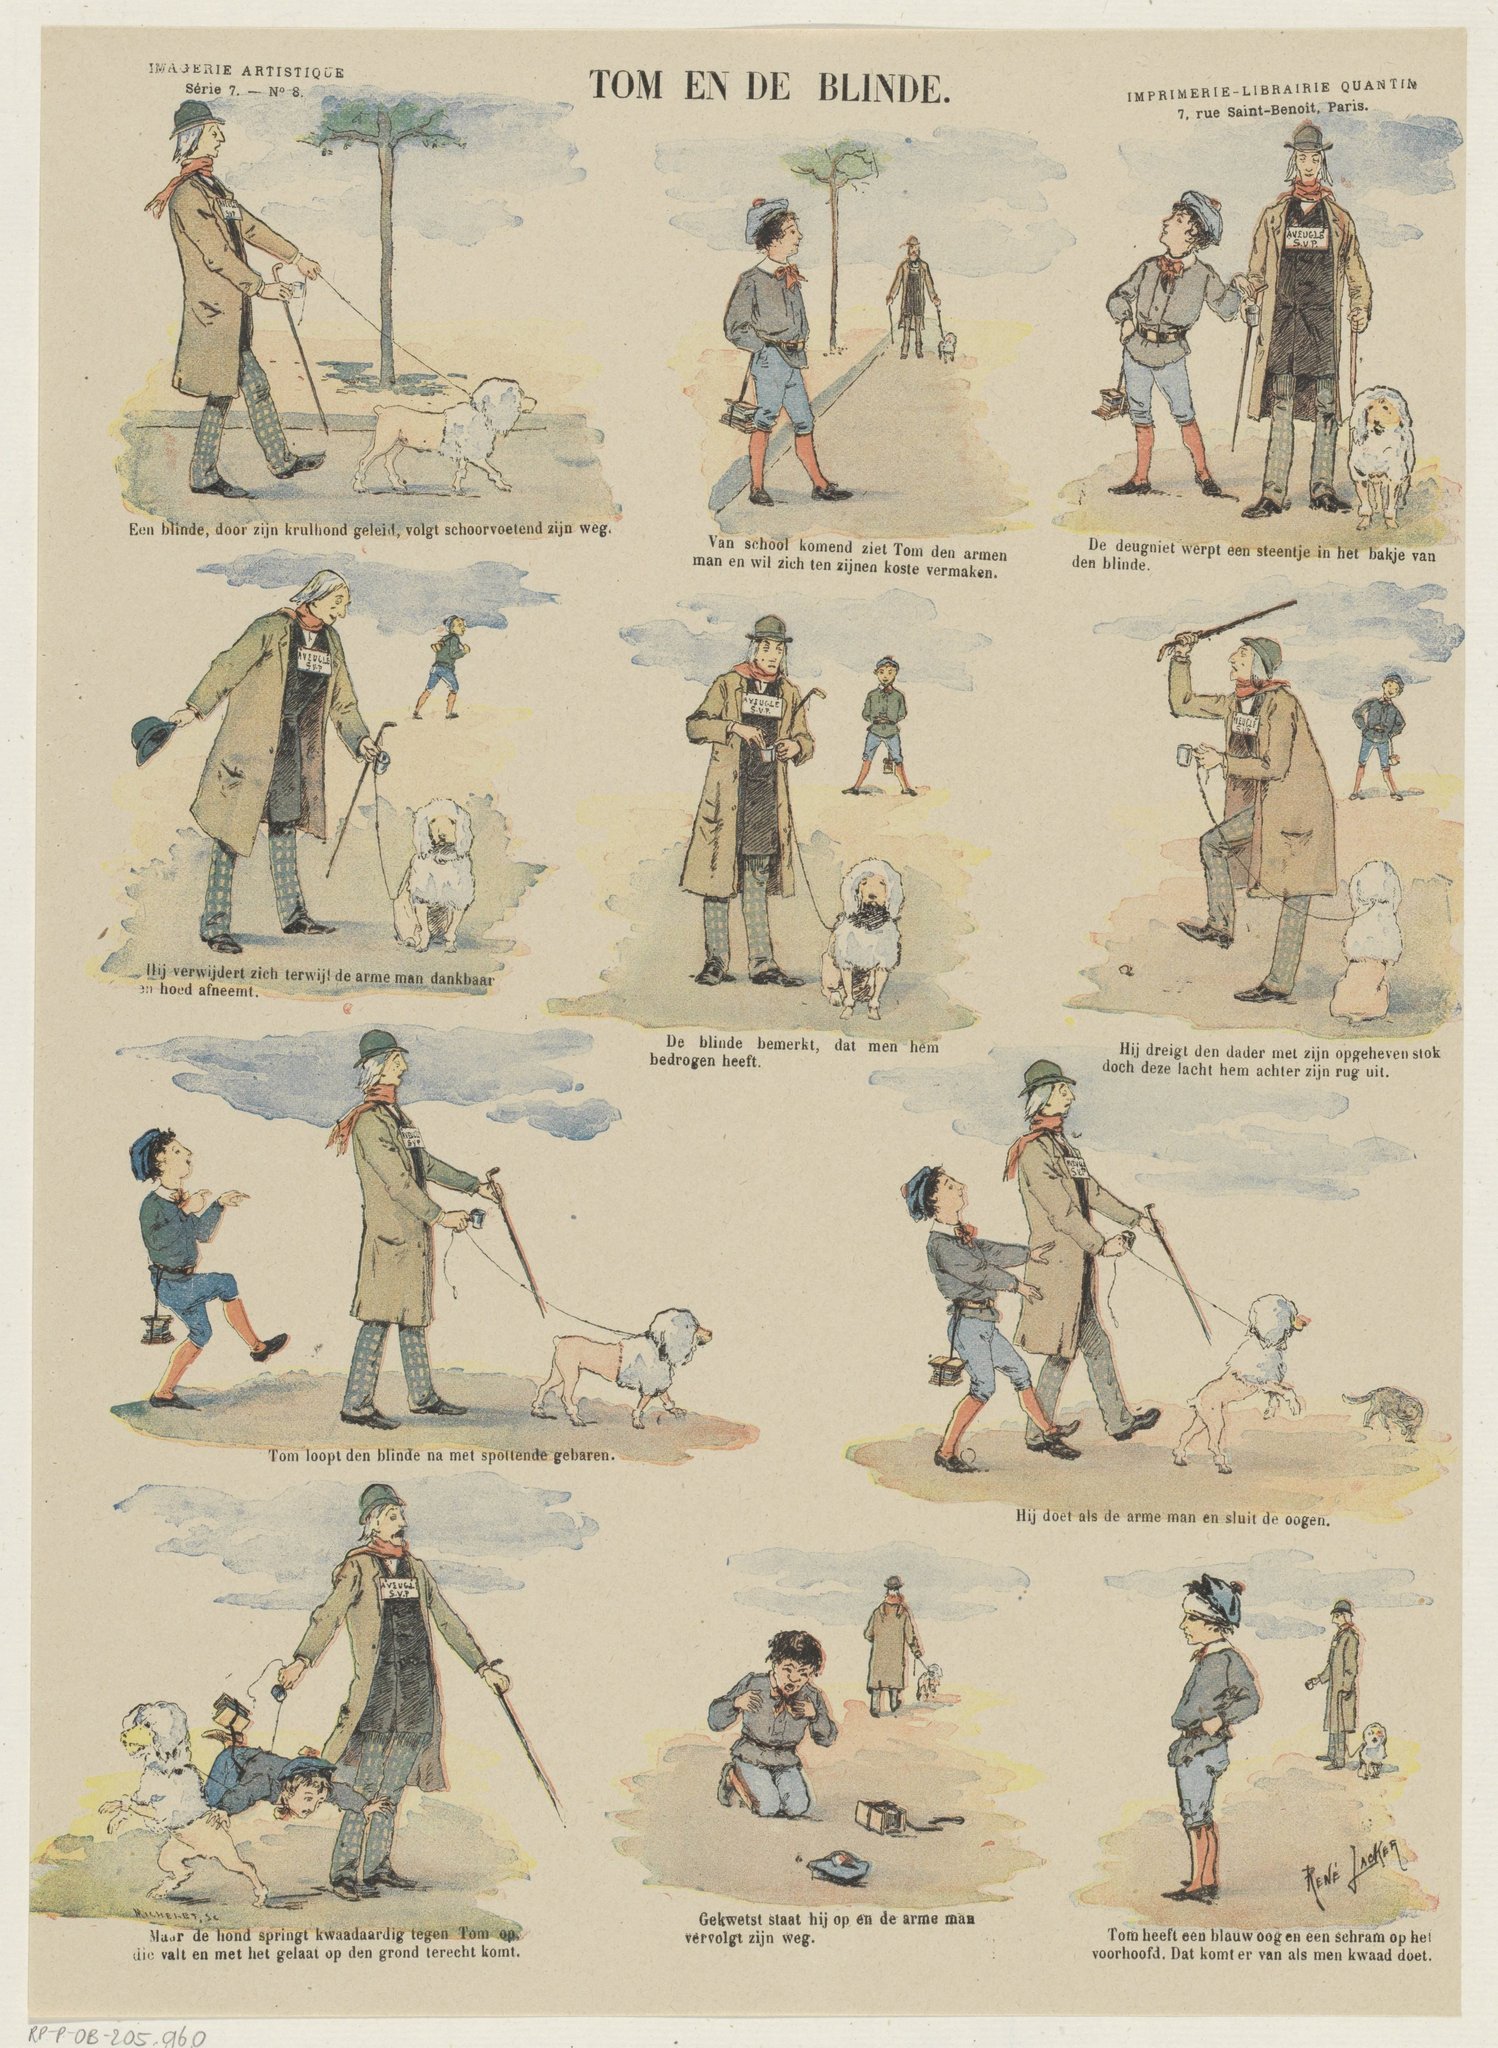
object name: popular print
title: Tom en de blinde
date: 1876-1890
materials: paper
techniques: lithograph, letterpress printing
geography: paris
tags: mischief-making play, blind, blindness, tales and fairy tales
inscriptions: collector's mark: Lugt 2760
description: Blad met 11 voorstellingen van de kwajongen Tom die een blinde man plaagt. Onder elke voorstelling een onderschrift. Genummerd linksboven: Série 7. - No. 8.